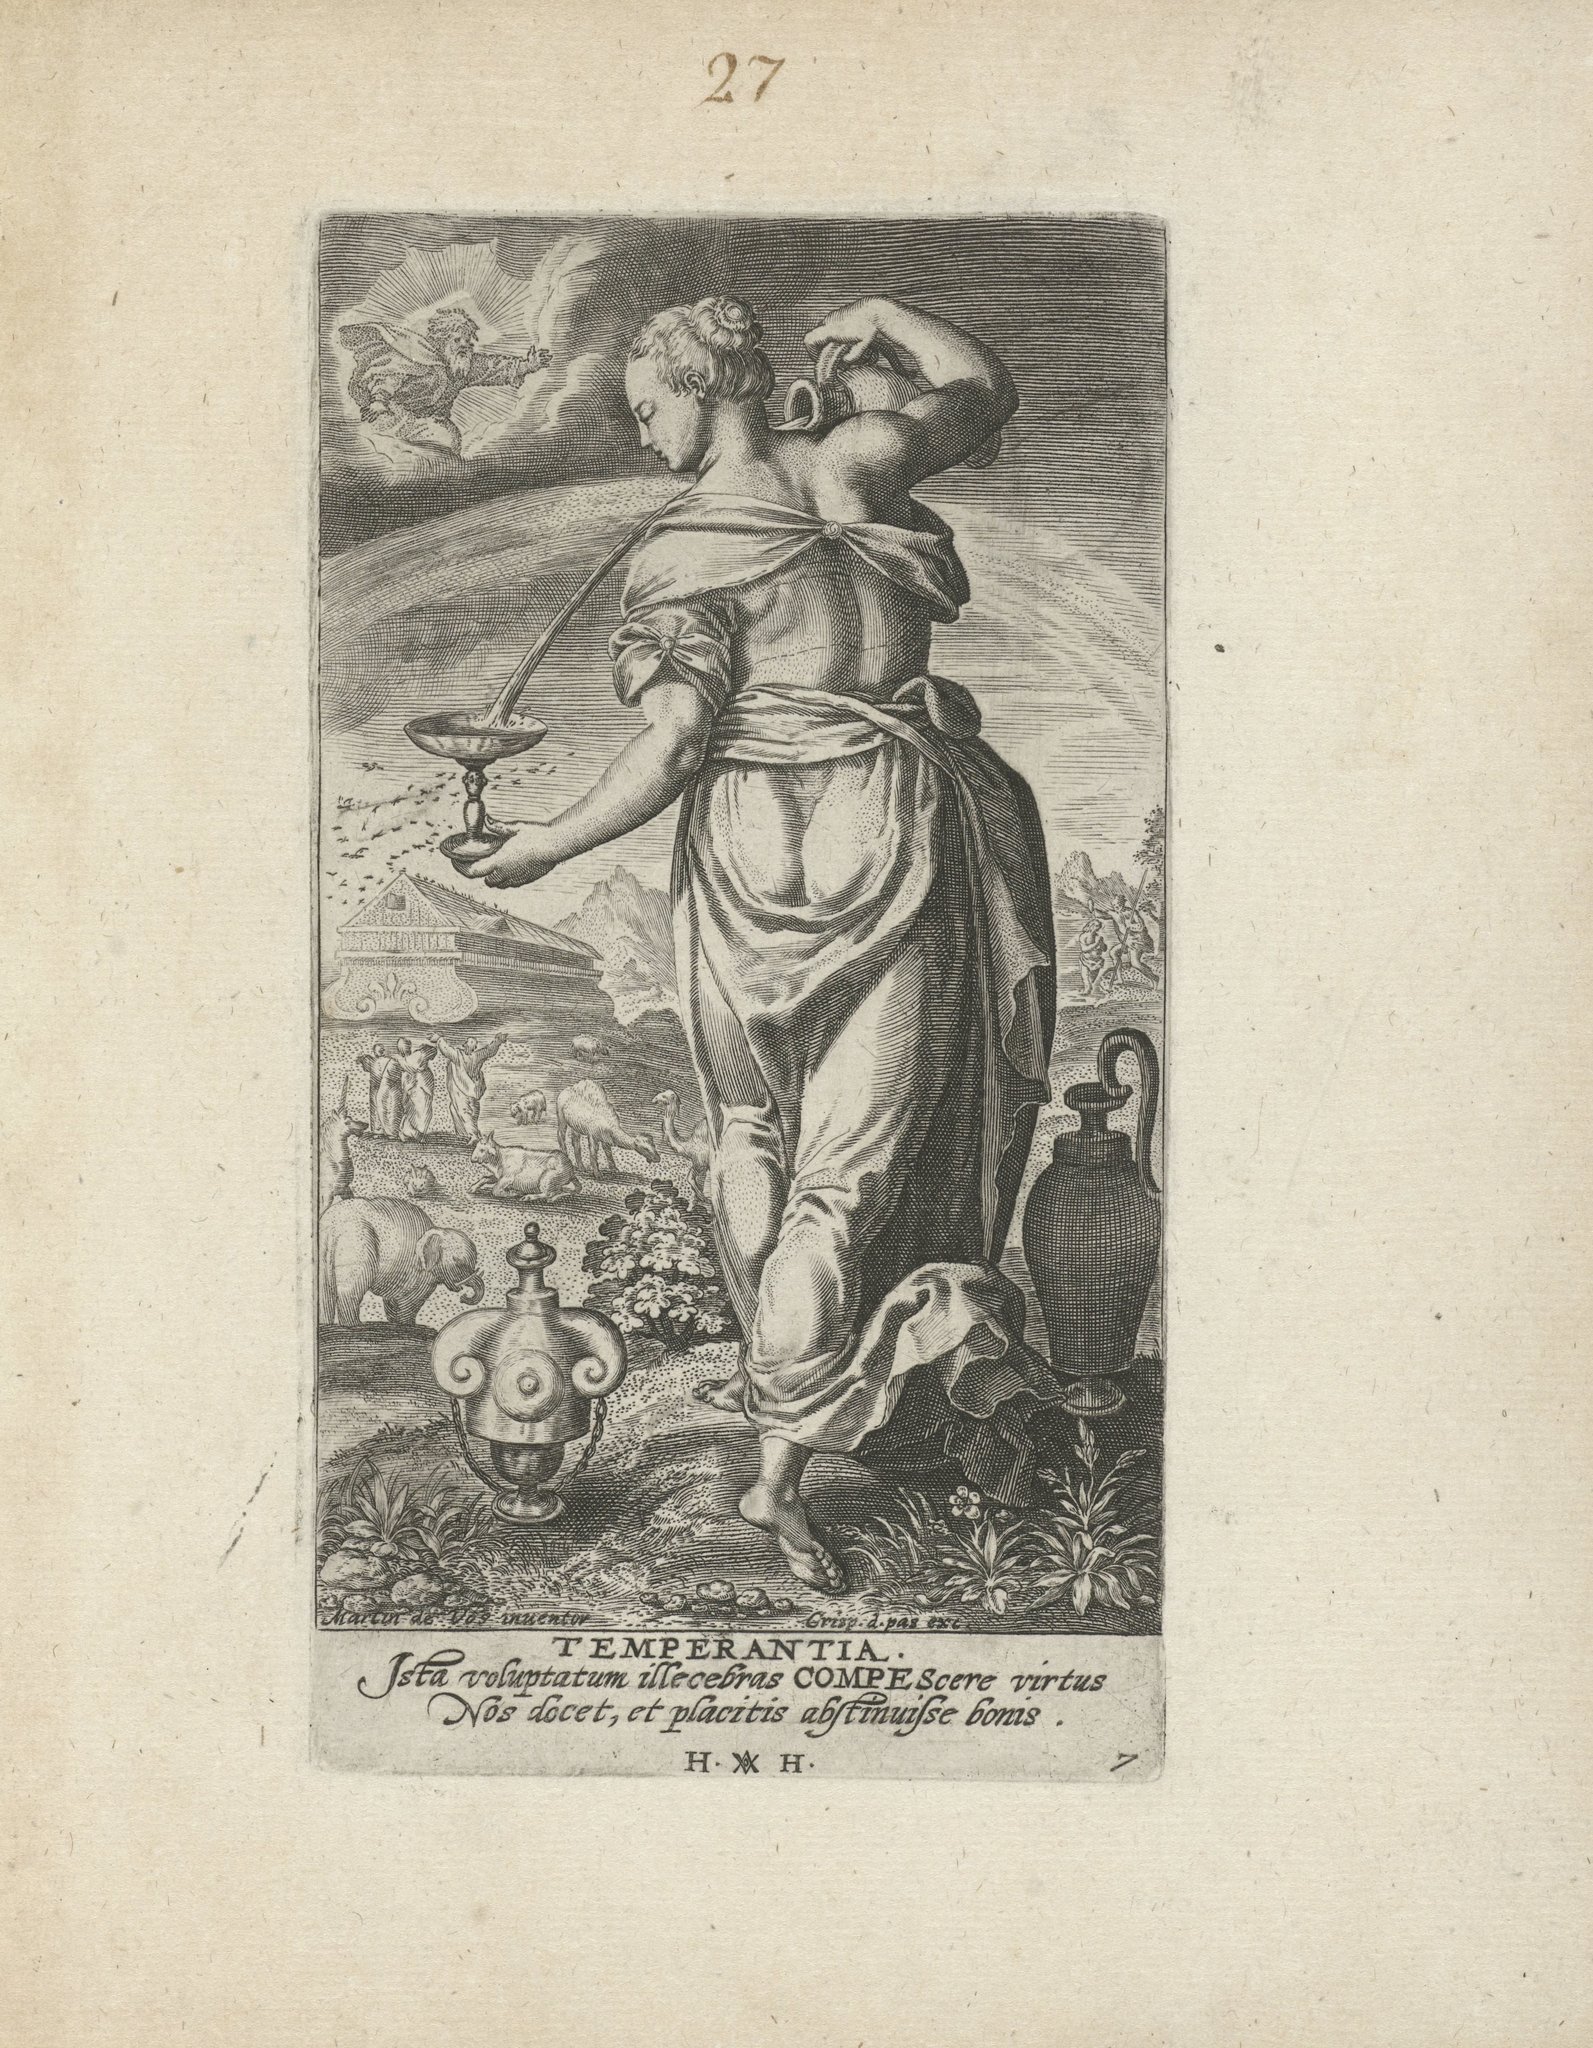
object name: print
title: Temperantia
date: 1580-1588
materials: paper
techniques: engraving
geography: antwerp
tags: john the baptist baptizing, temperance, 'temperantia'; 'temperanza' (ripa) ~ one of the four cardinal virtues, the building of the ark, and the embarkation (genesis 7:5-9)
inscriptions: collector's mark: Lugt 2760, number: ‘27’, collector's mark: Lugt 2228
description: Landschap met de vrouwelijke personificatie van Matigheid (Temperantia), een van de vier kardinale deugden. In haar handen draagt ze een kruik met vloeistof die ze overgiet in een schaal. Links op de achtergrond de ark van Noach en God de Vader die aan de hemel verschijnt. Rechts op de achtergrond de doop in de Jordaan. In de marge een tweeregelig onderschrift in het Latijn. Zevende prent uit een serie met deugden.